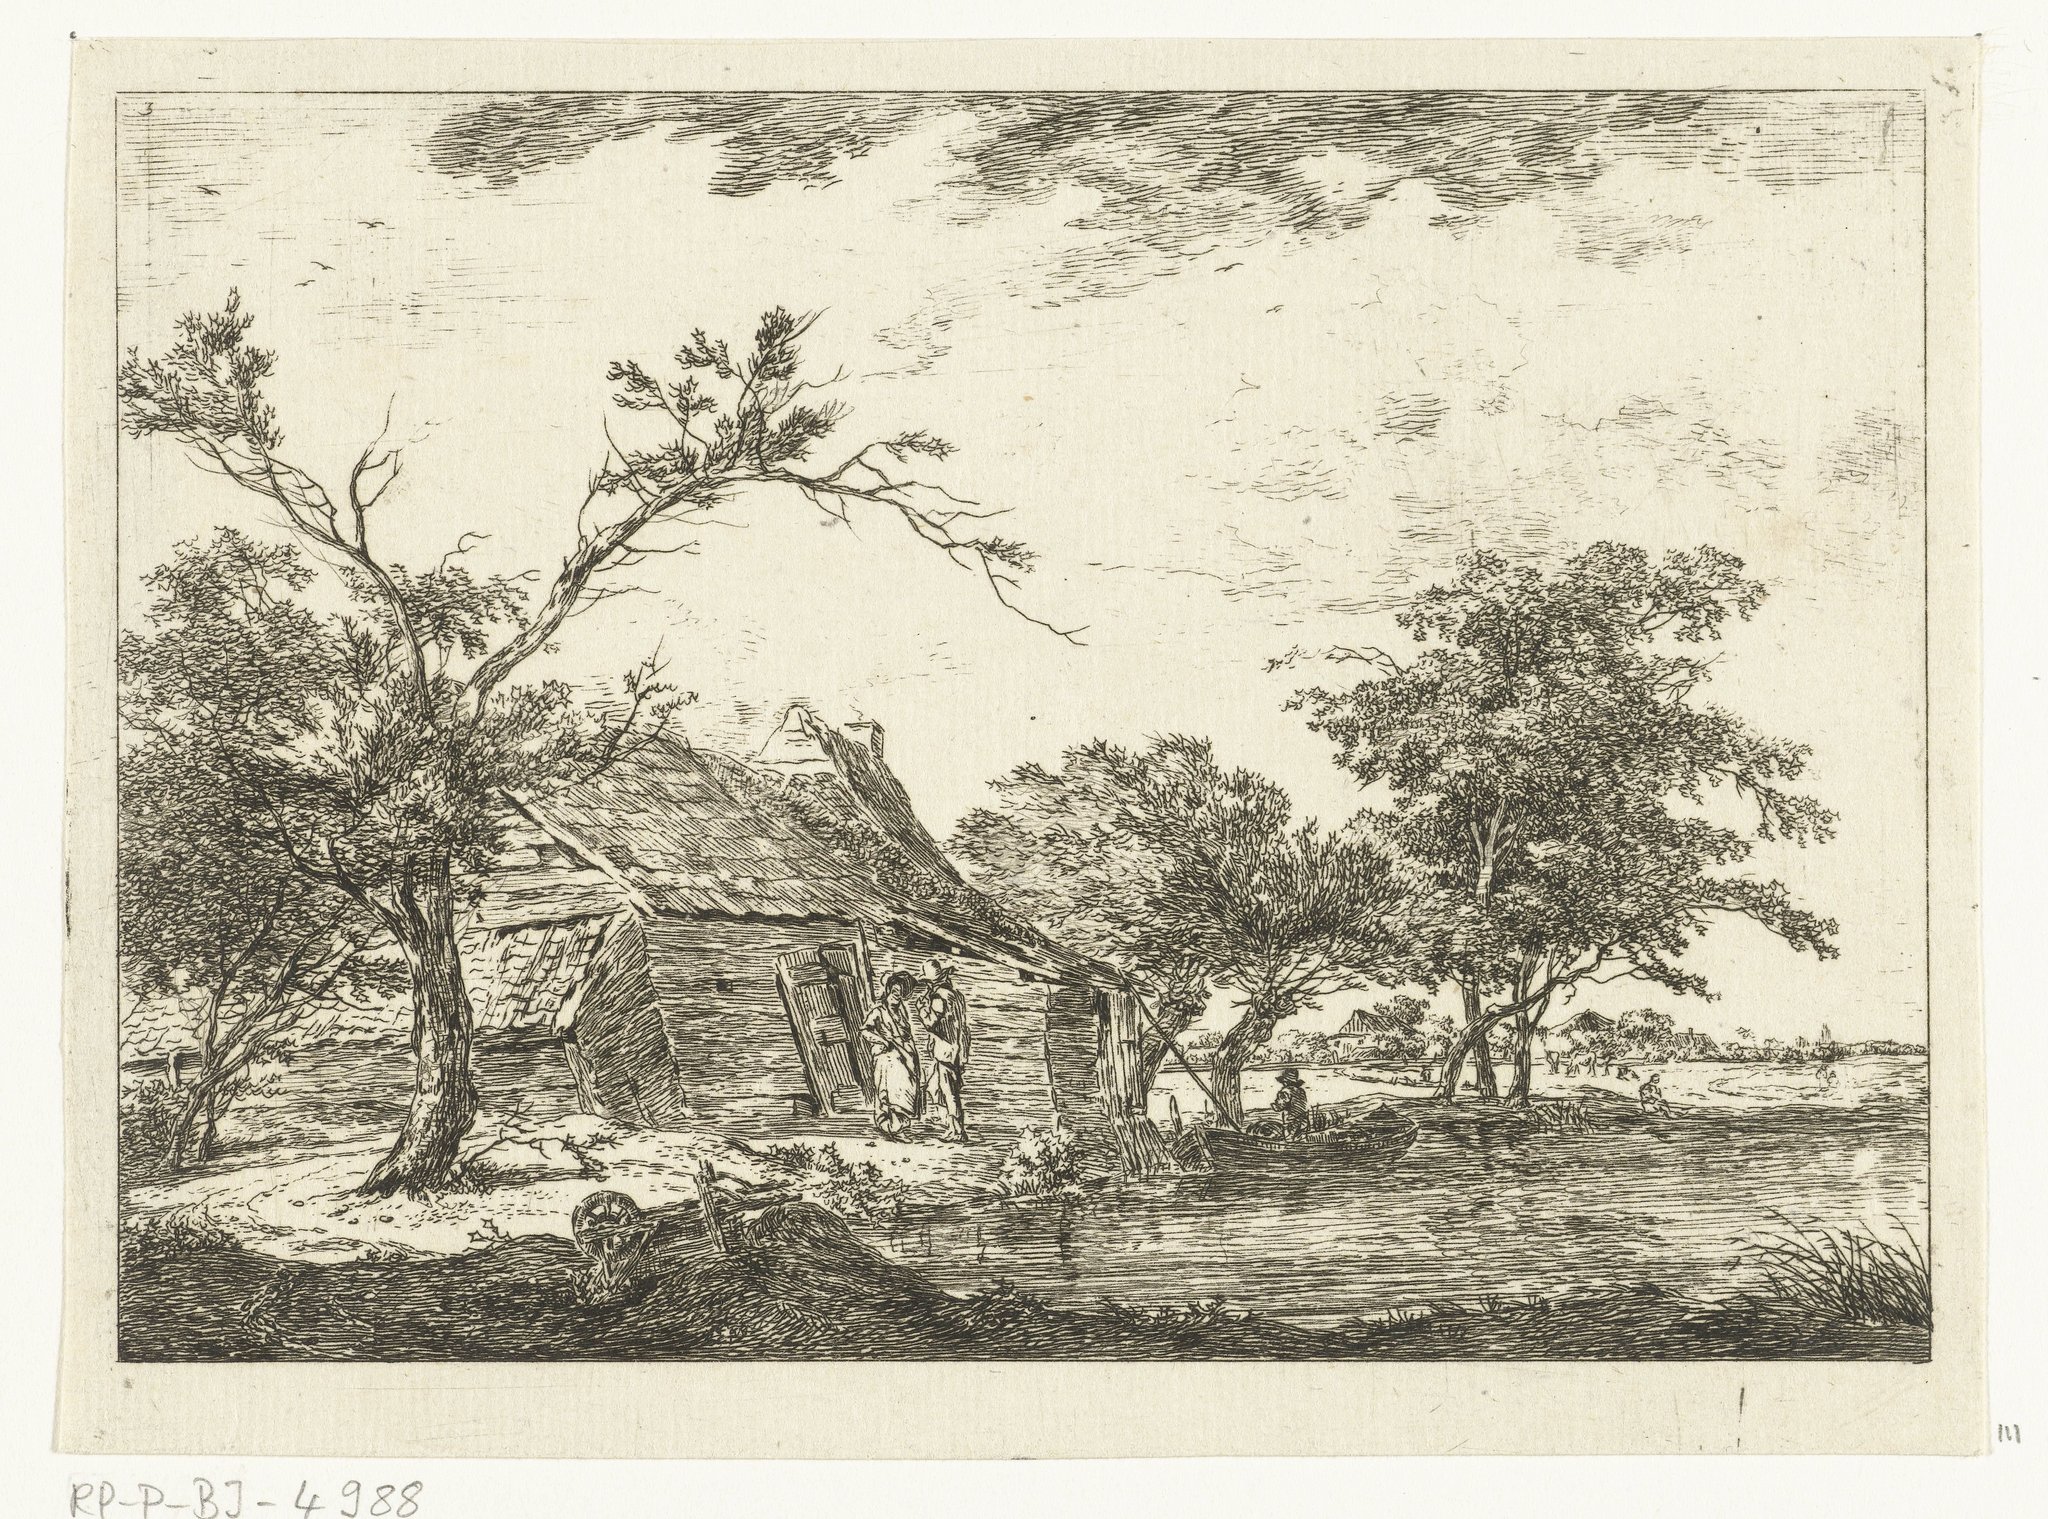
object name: print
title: Pratend stel bij boerderij aan waterkant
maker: hermanus van brussel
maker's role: draughtsman, print maker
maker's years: 1763-1815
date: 1800-1815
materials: paper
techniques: etching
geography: netherlands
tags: landscapes in the temperate zone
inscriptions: collector's mark: Lugt 2228